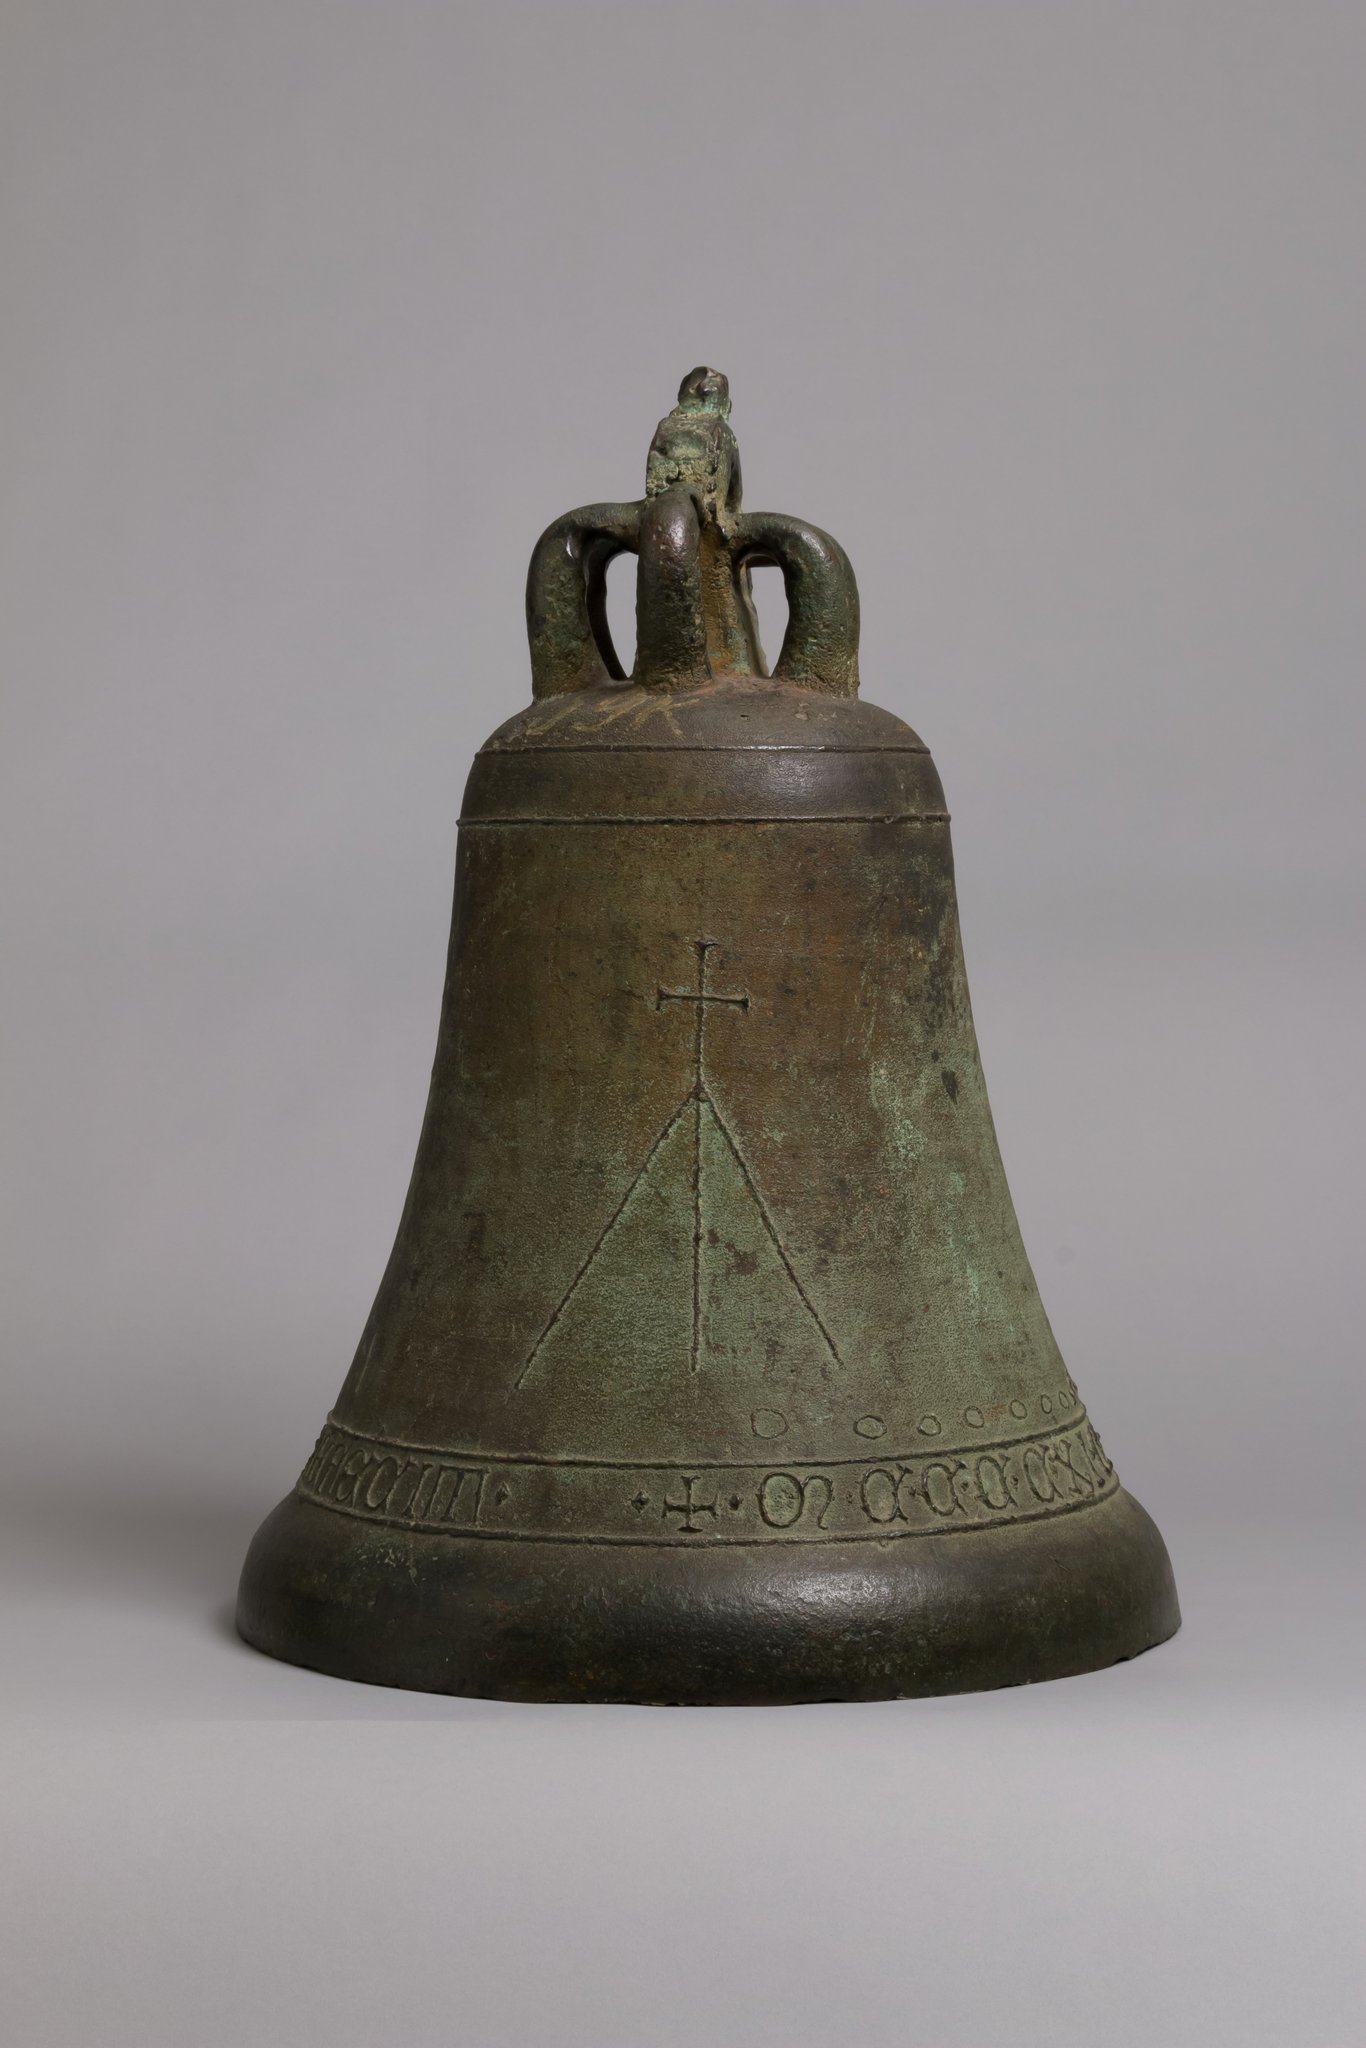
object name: bell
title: Church Bell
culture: north italian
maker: master marcus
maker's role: artist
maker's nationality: venetian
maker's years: 1396-1411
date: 1411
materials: bronze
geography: italy